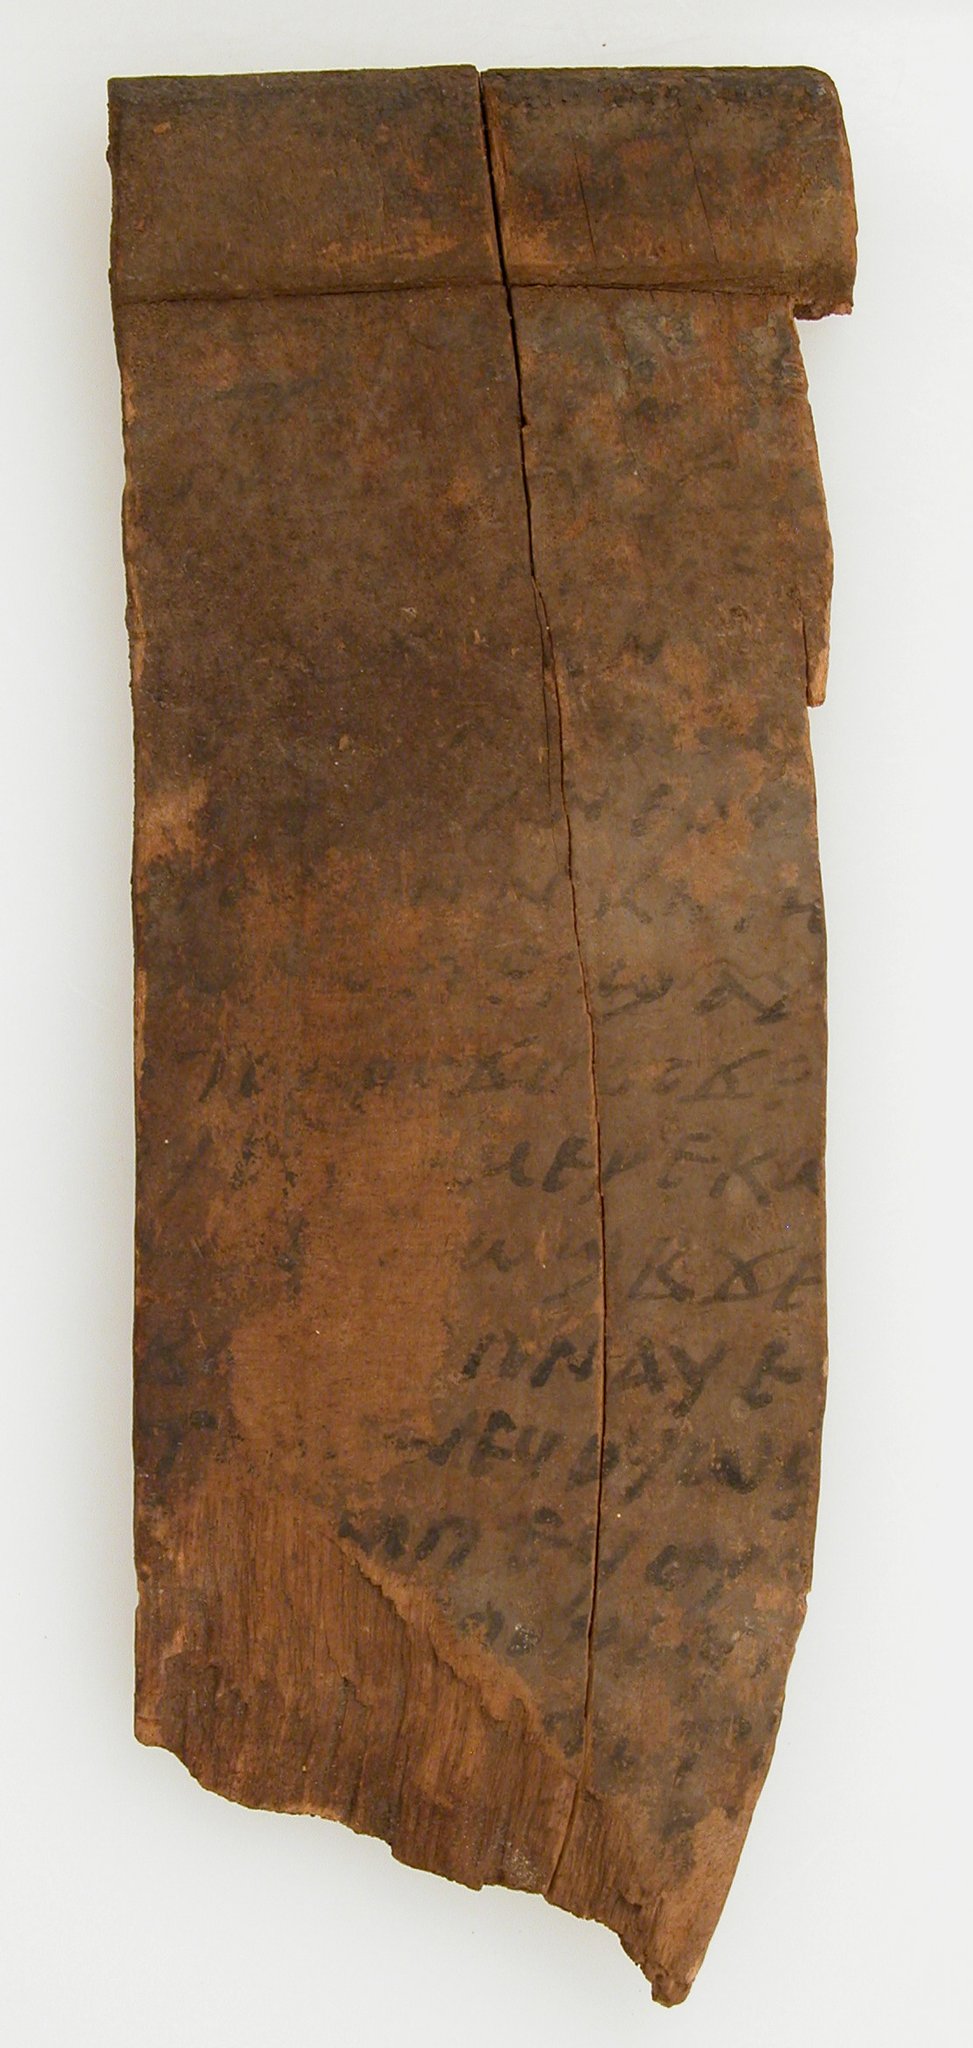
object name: ostrakon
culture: coptic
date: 600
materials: ink, wood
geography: egypt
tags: coptic,documents